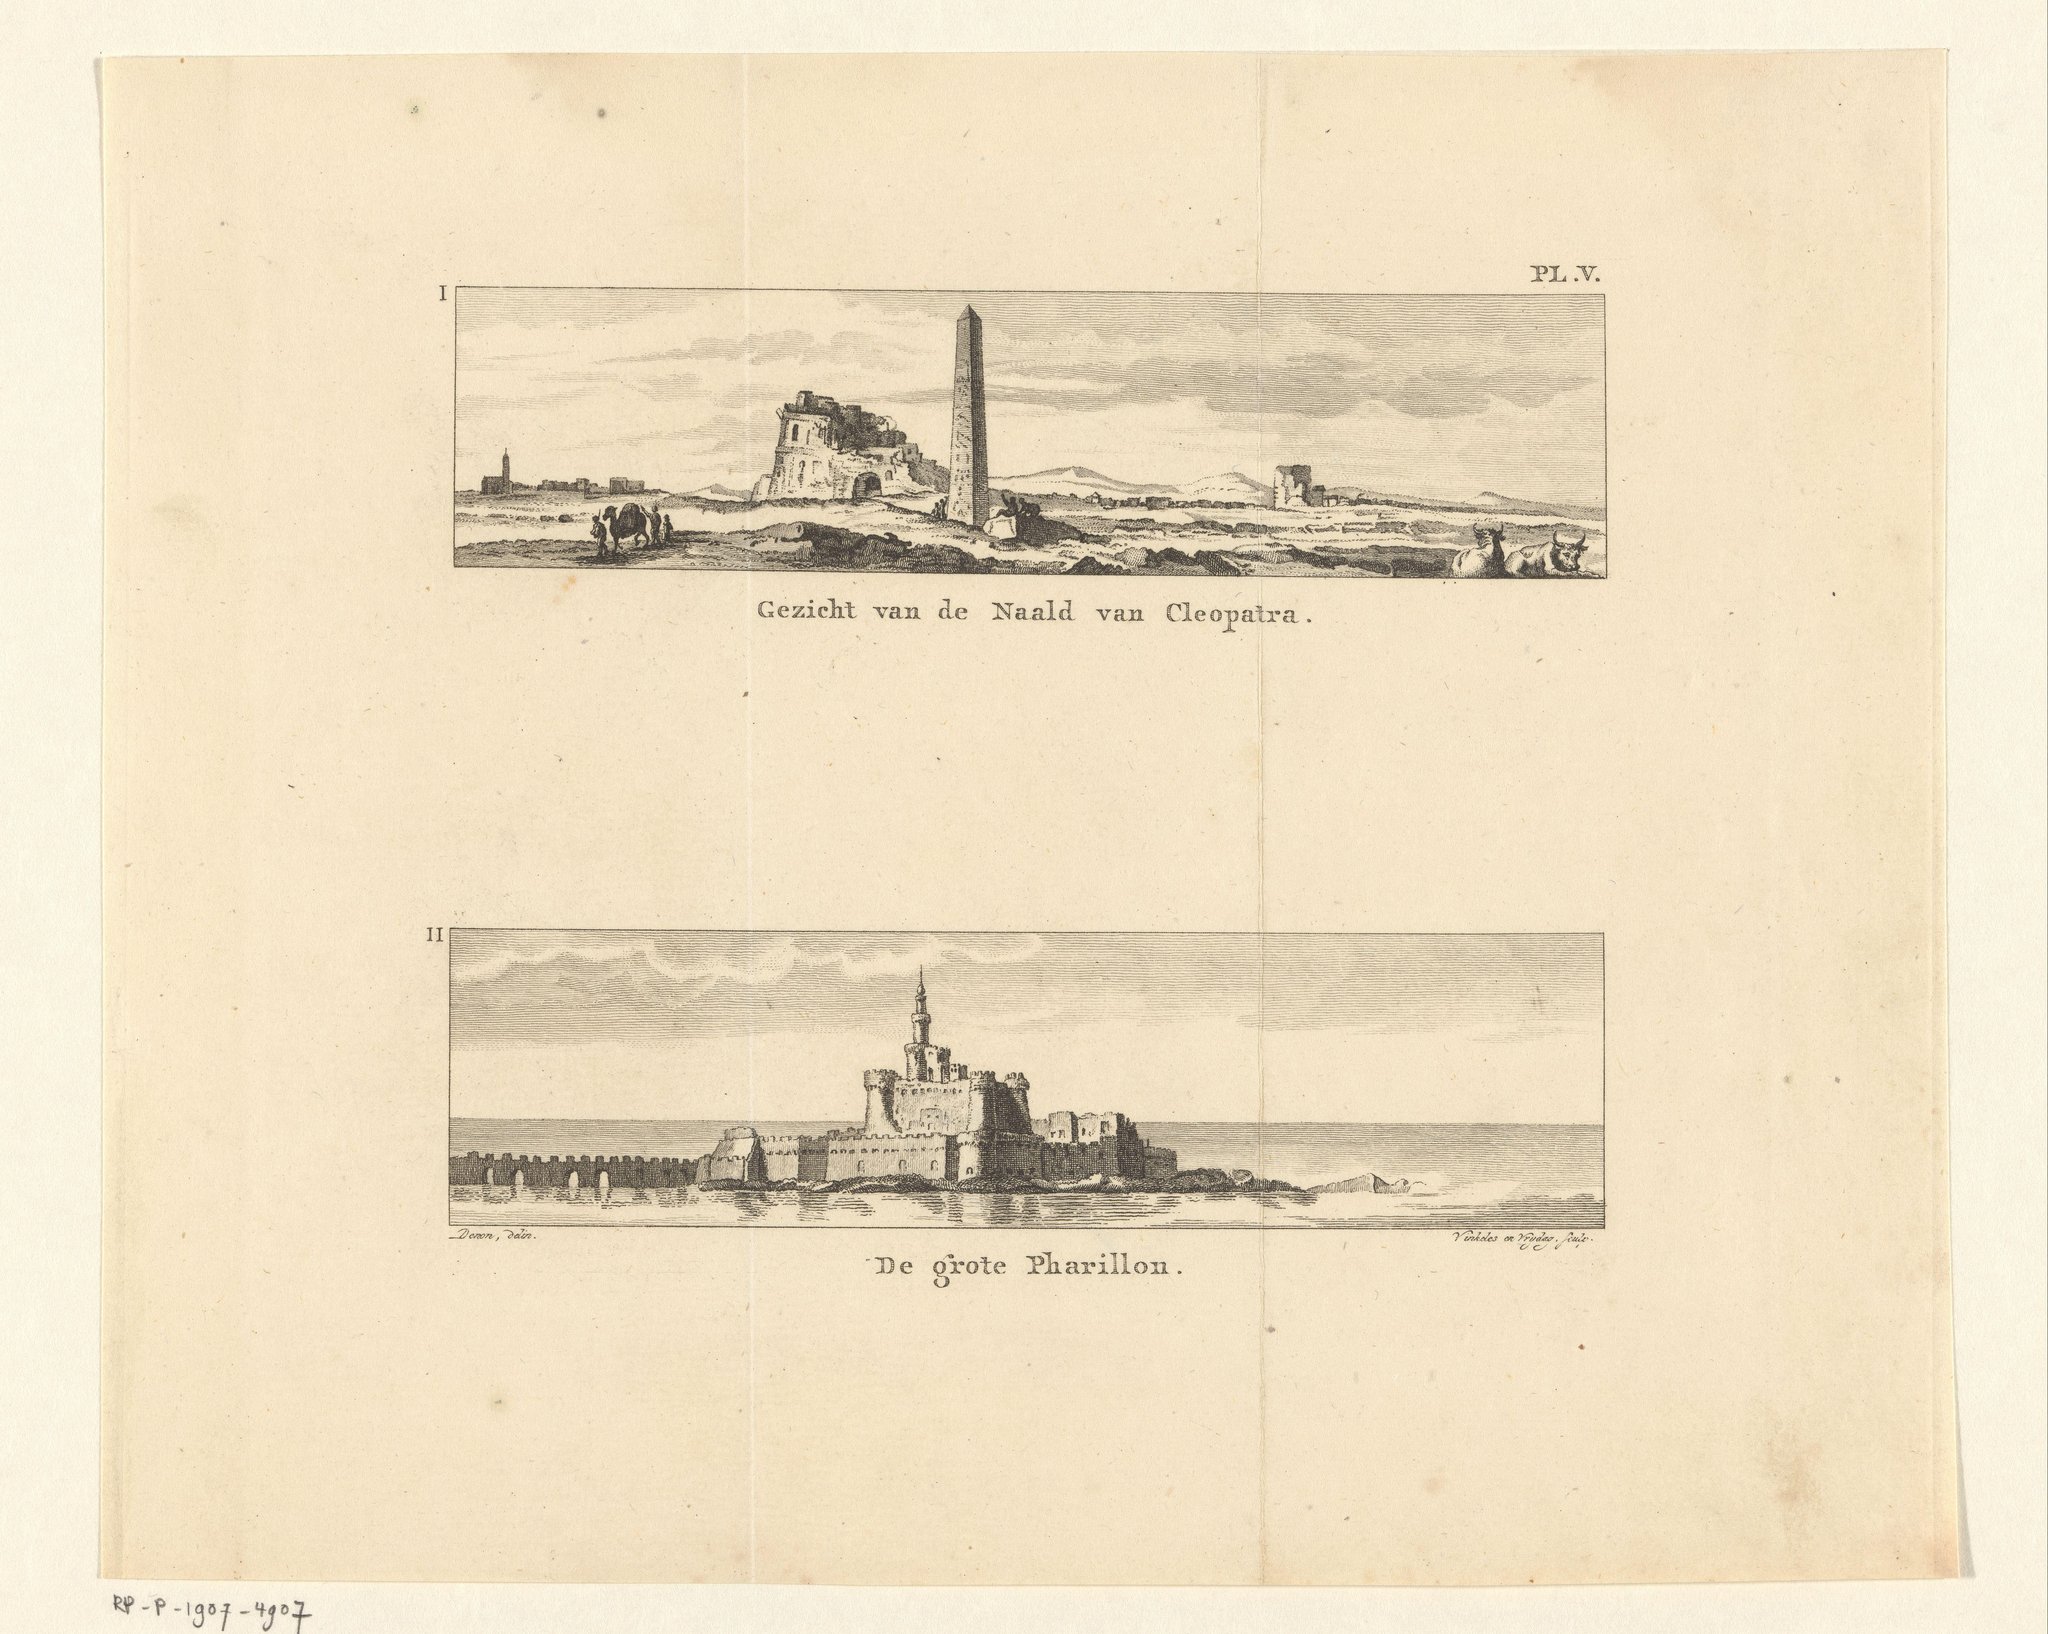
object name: book illustration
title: Gezicht van de naald van Cleoptatra/ De grote Pharillon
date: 1803-1805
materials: paper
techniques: etching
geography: amsterdam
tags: obelisk, needle, pharos of alexandria (wonder of the world)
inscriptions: collector's mark: Lugt 2228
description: Prent vermoedelijk gebruikt in: Denon, Dominique Vivant [vertaald door Herman Bosscha]. Reize in Opper- en Neder-Egipte, gedurende den veldtocht van Bonaparte. 3 dln. Amsterdam: Johannes Allart, 1803-1805.